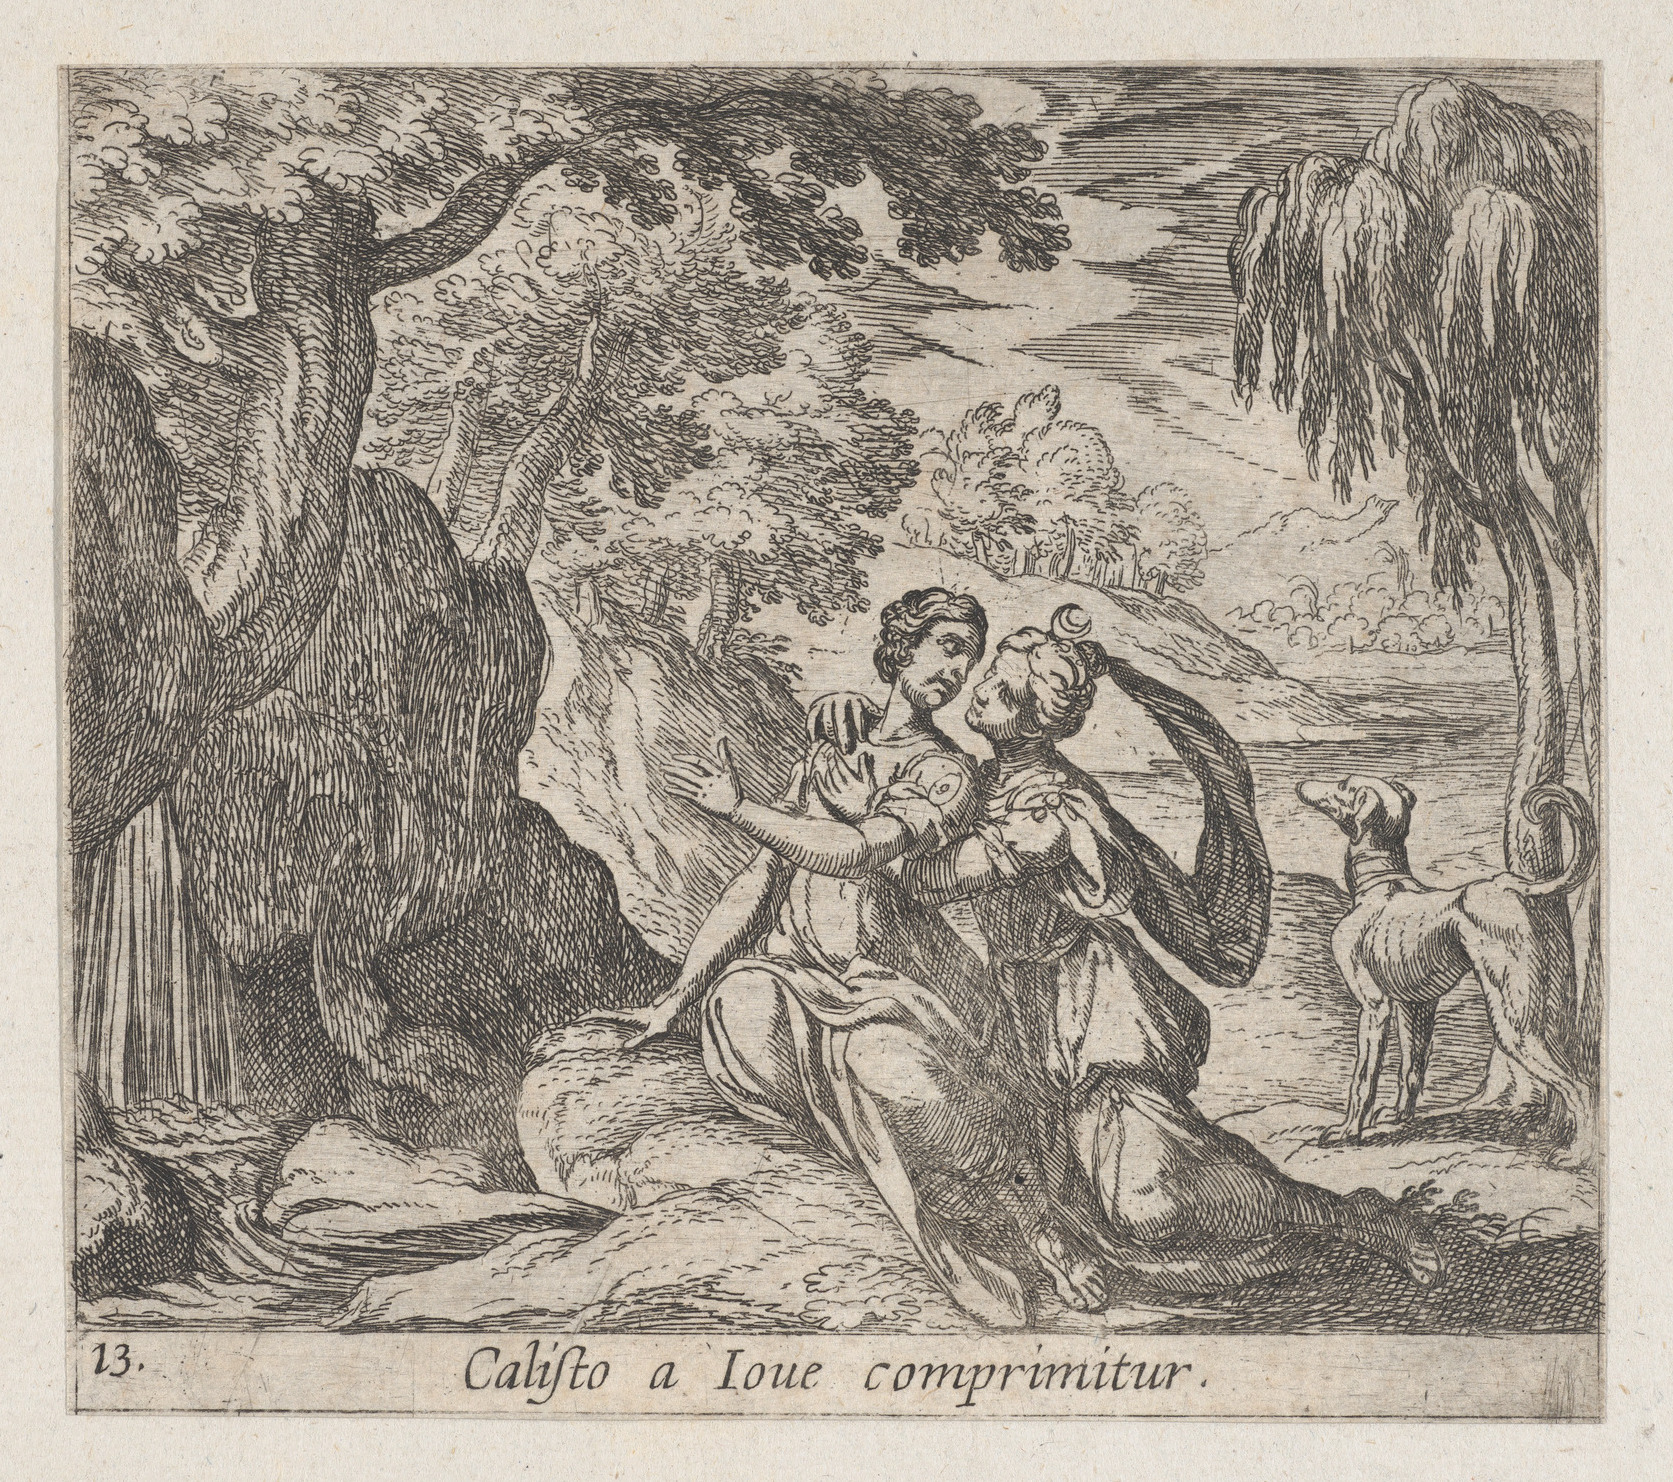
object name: print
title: Plate 13:Jupiter and Callisto (Calisto a Iove comprimitur), from Ovid's 'Metamorphoses'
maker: antonio tempesta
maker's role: artist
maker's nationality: italian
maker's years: 1555-1630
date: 1606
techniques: etching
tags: jupiter,dogs